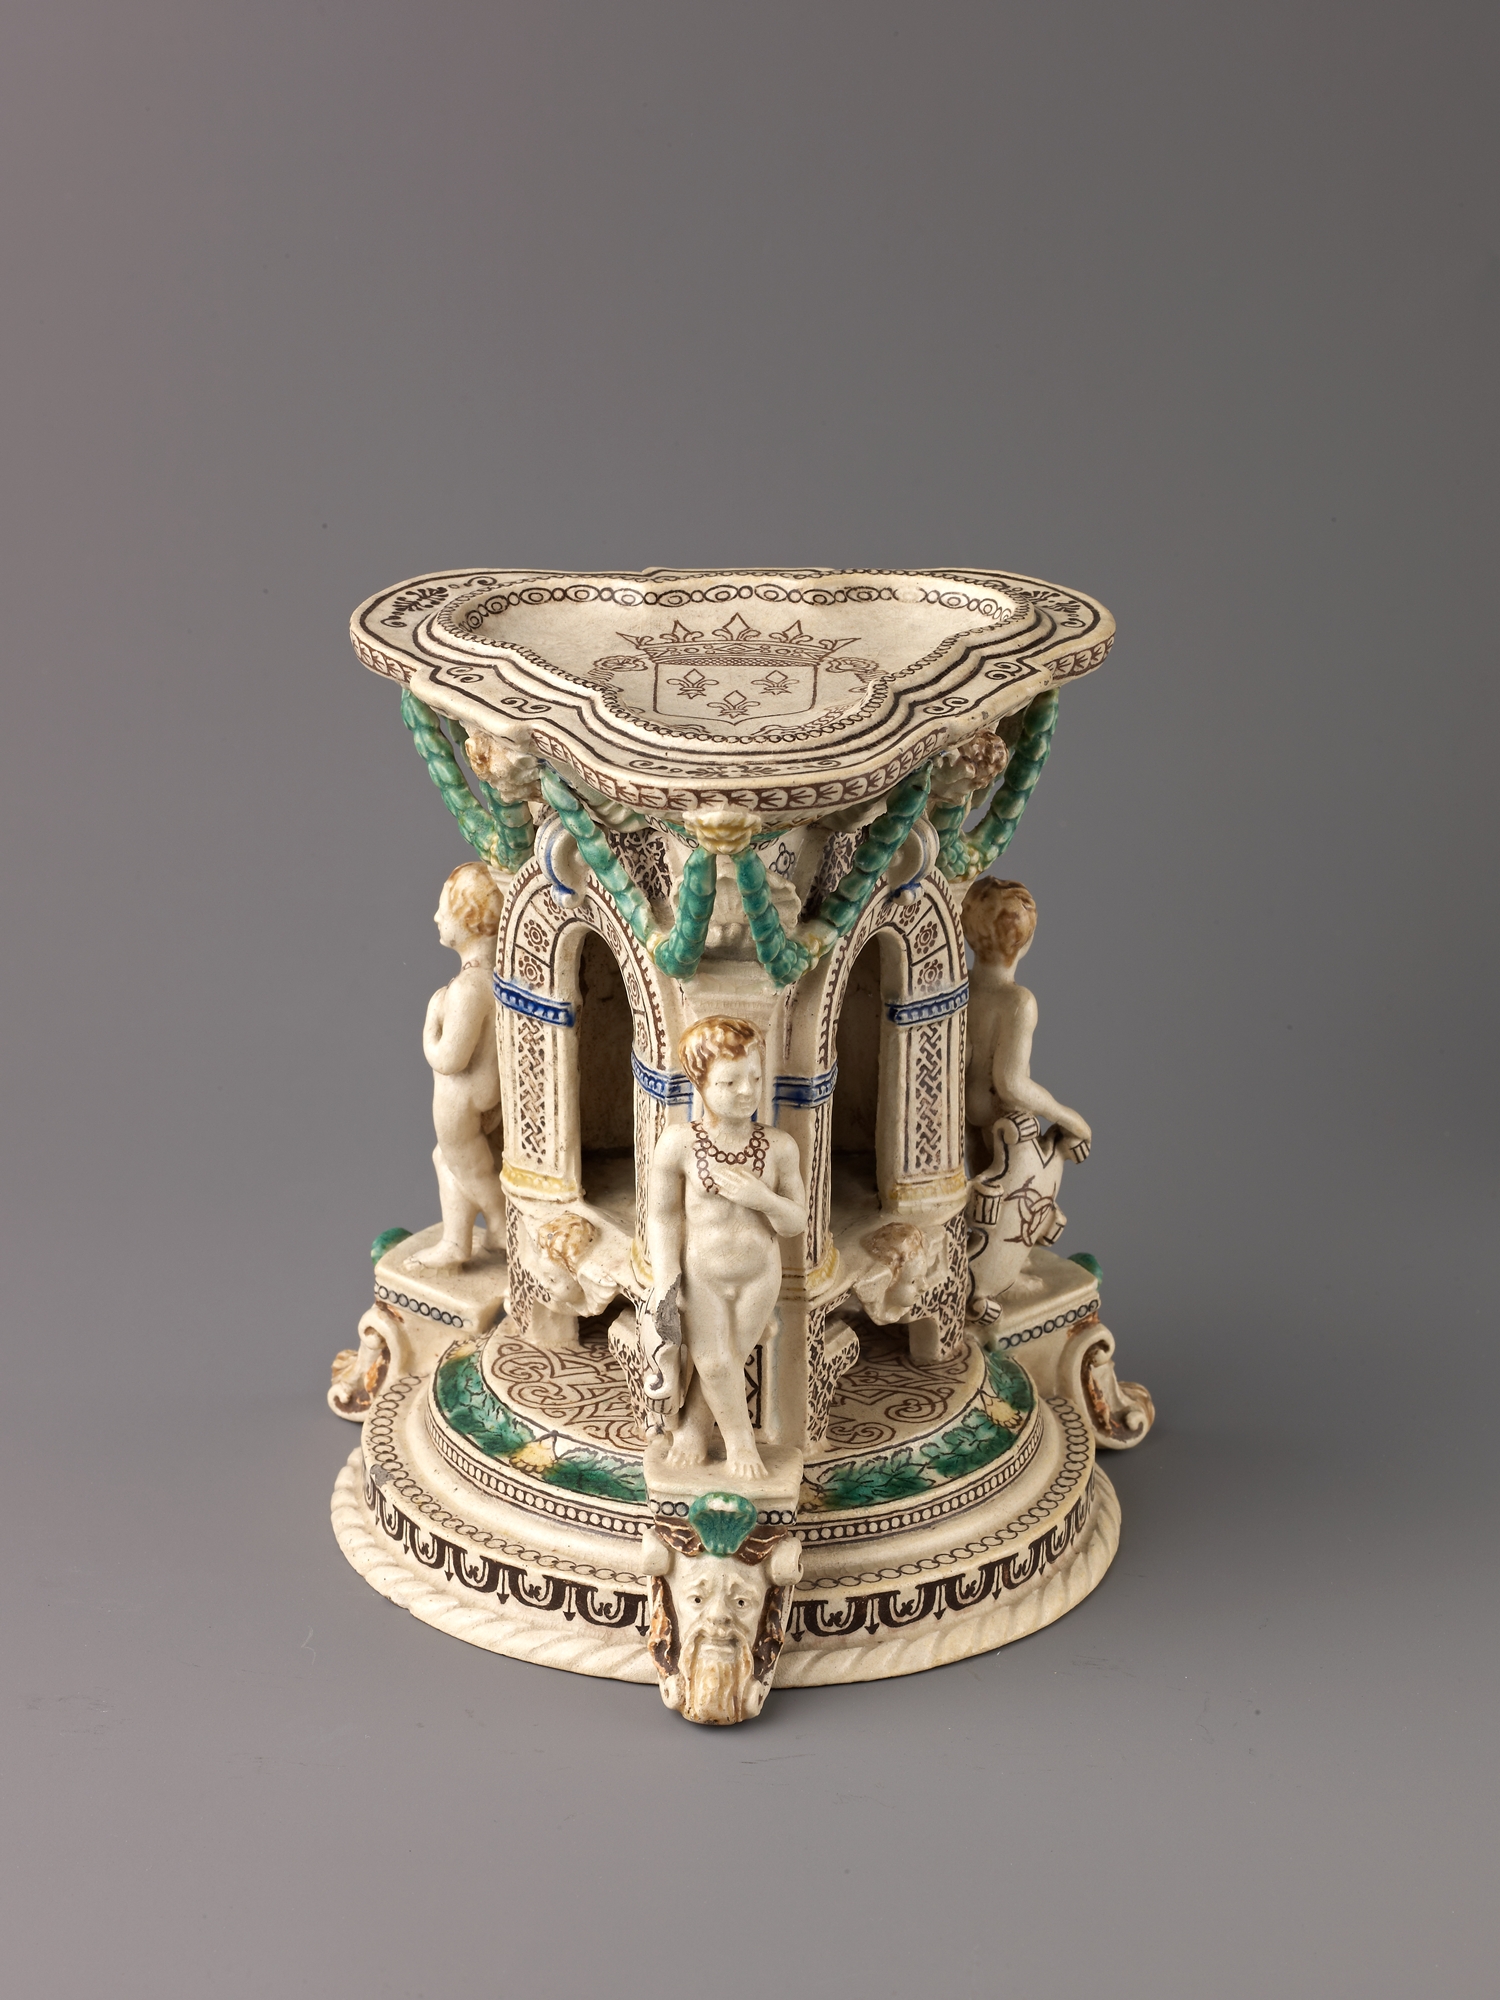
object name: saltcellar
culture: french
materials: clay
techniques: inlay, tinting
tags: boys,male nudes,coat of arms